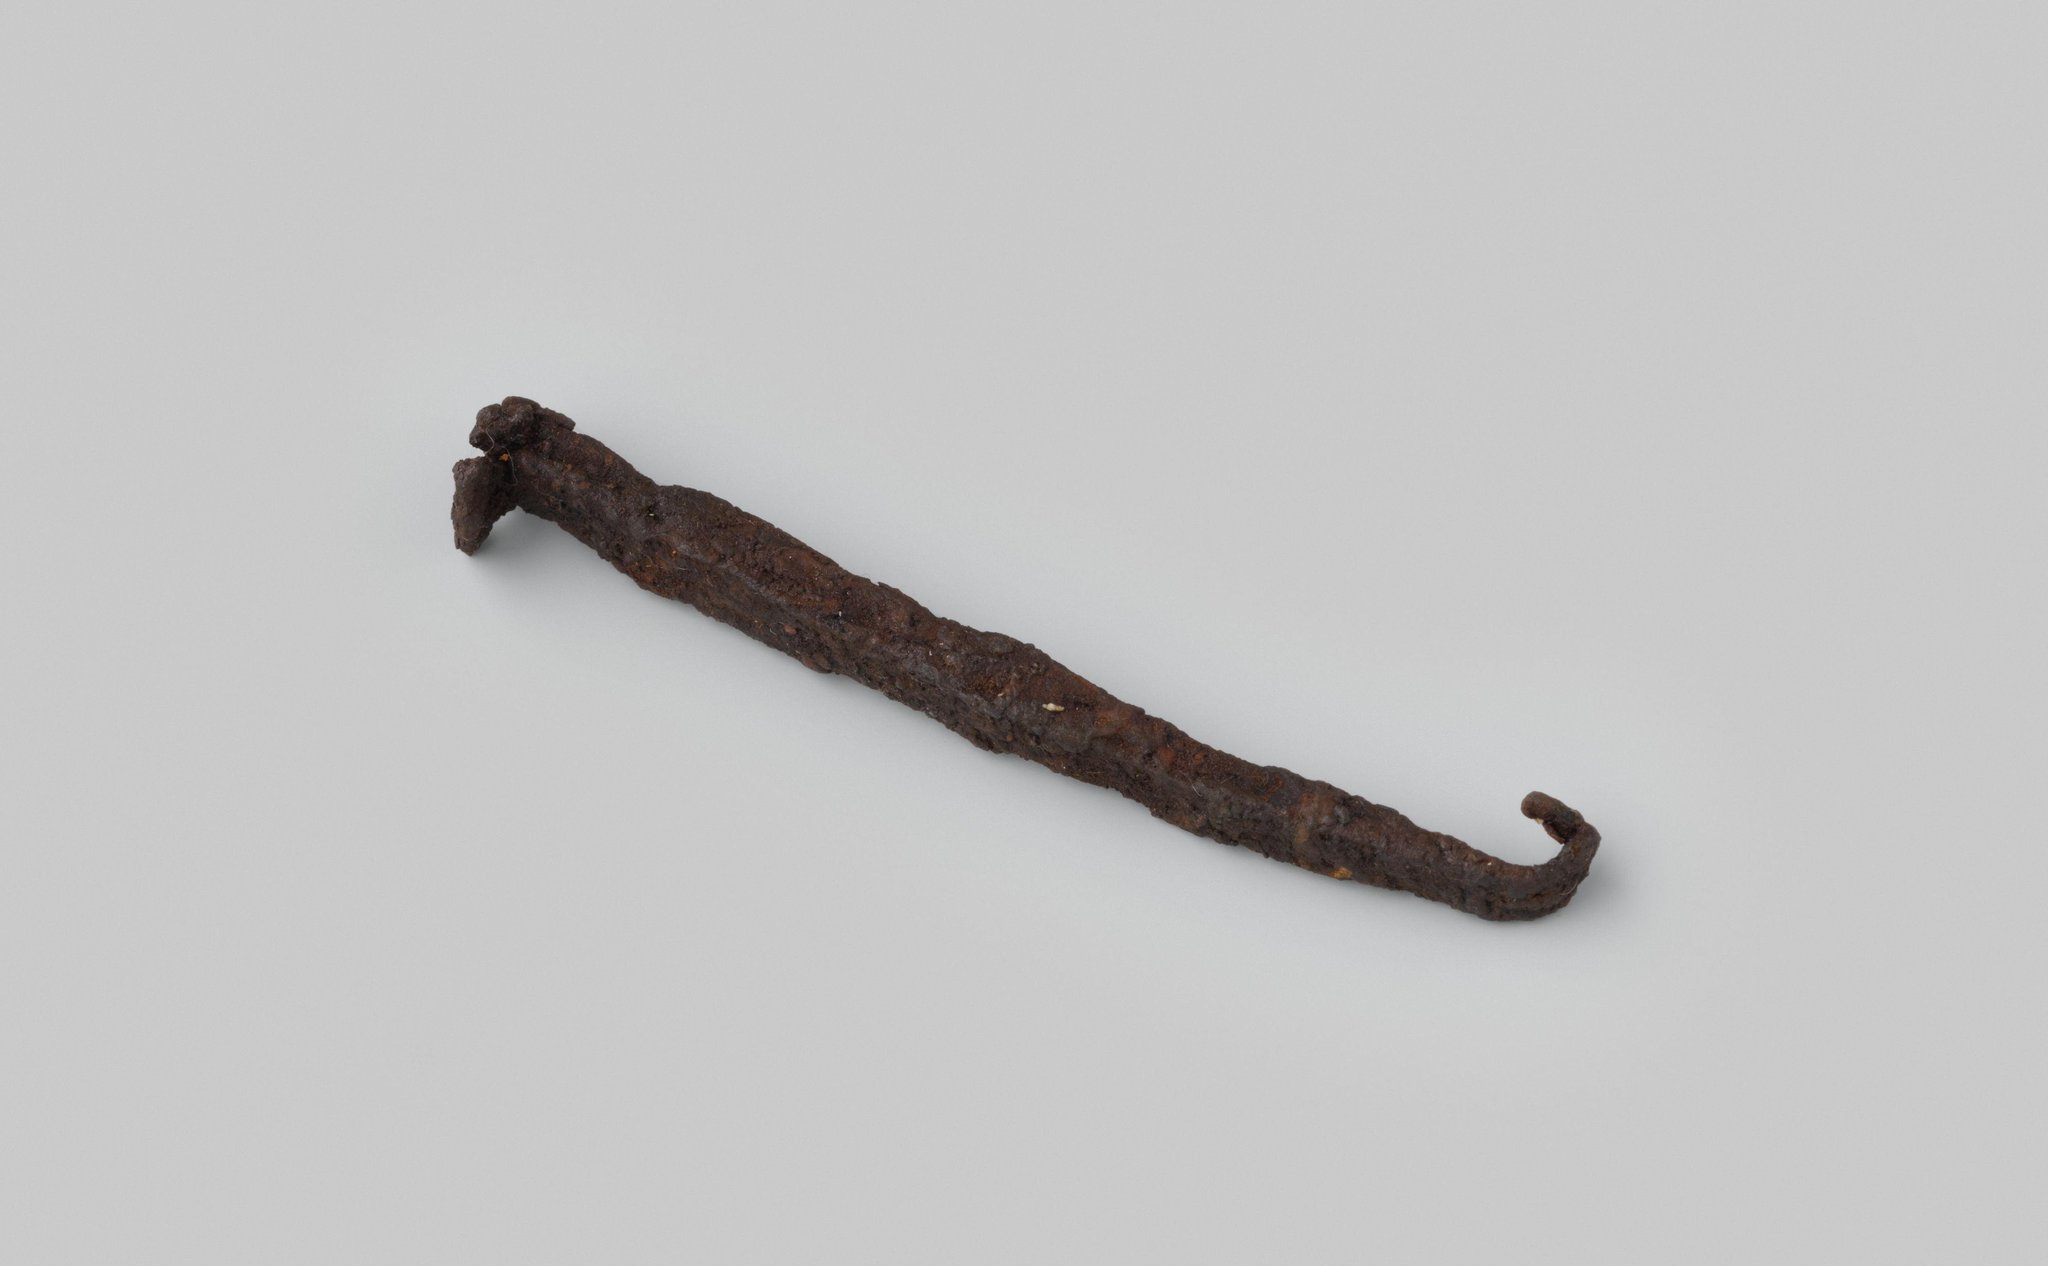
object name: nagel, spijker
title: Spijker afkomstig uit het wrak van de Oost-Indiëvaarder Hollandia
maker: Anonymous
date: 1700-1743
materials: iron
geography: netherlands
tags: verenigde oostindische compagnie, hollandia (schip)